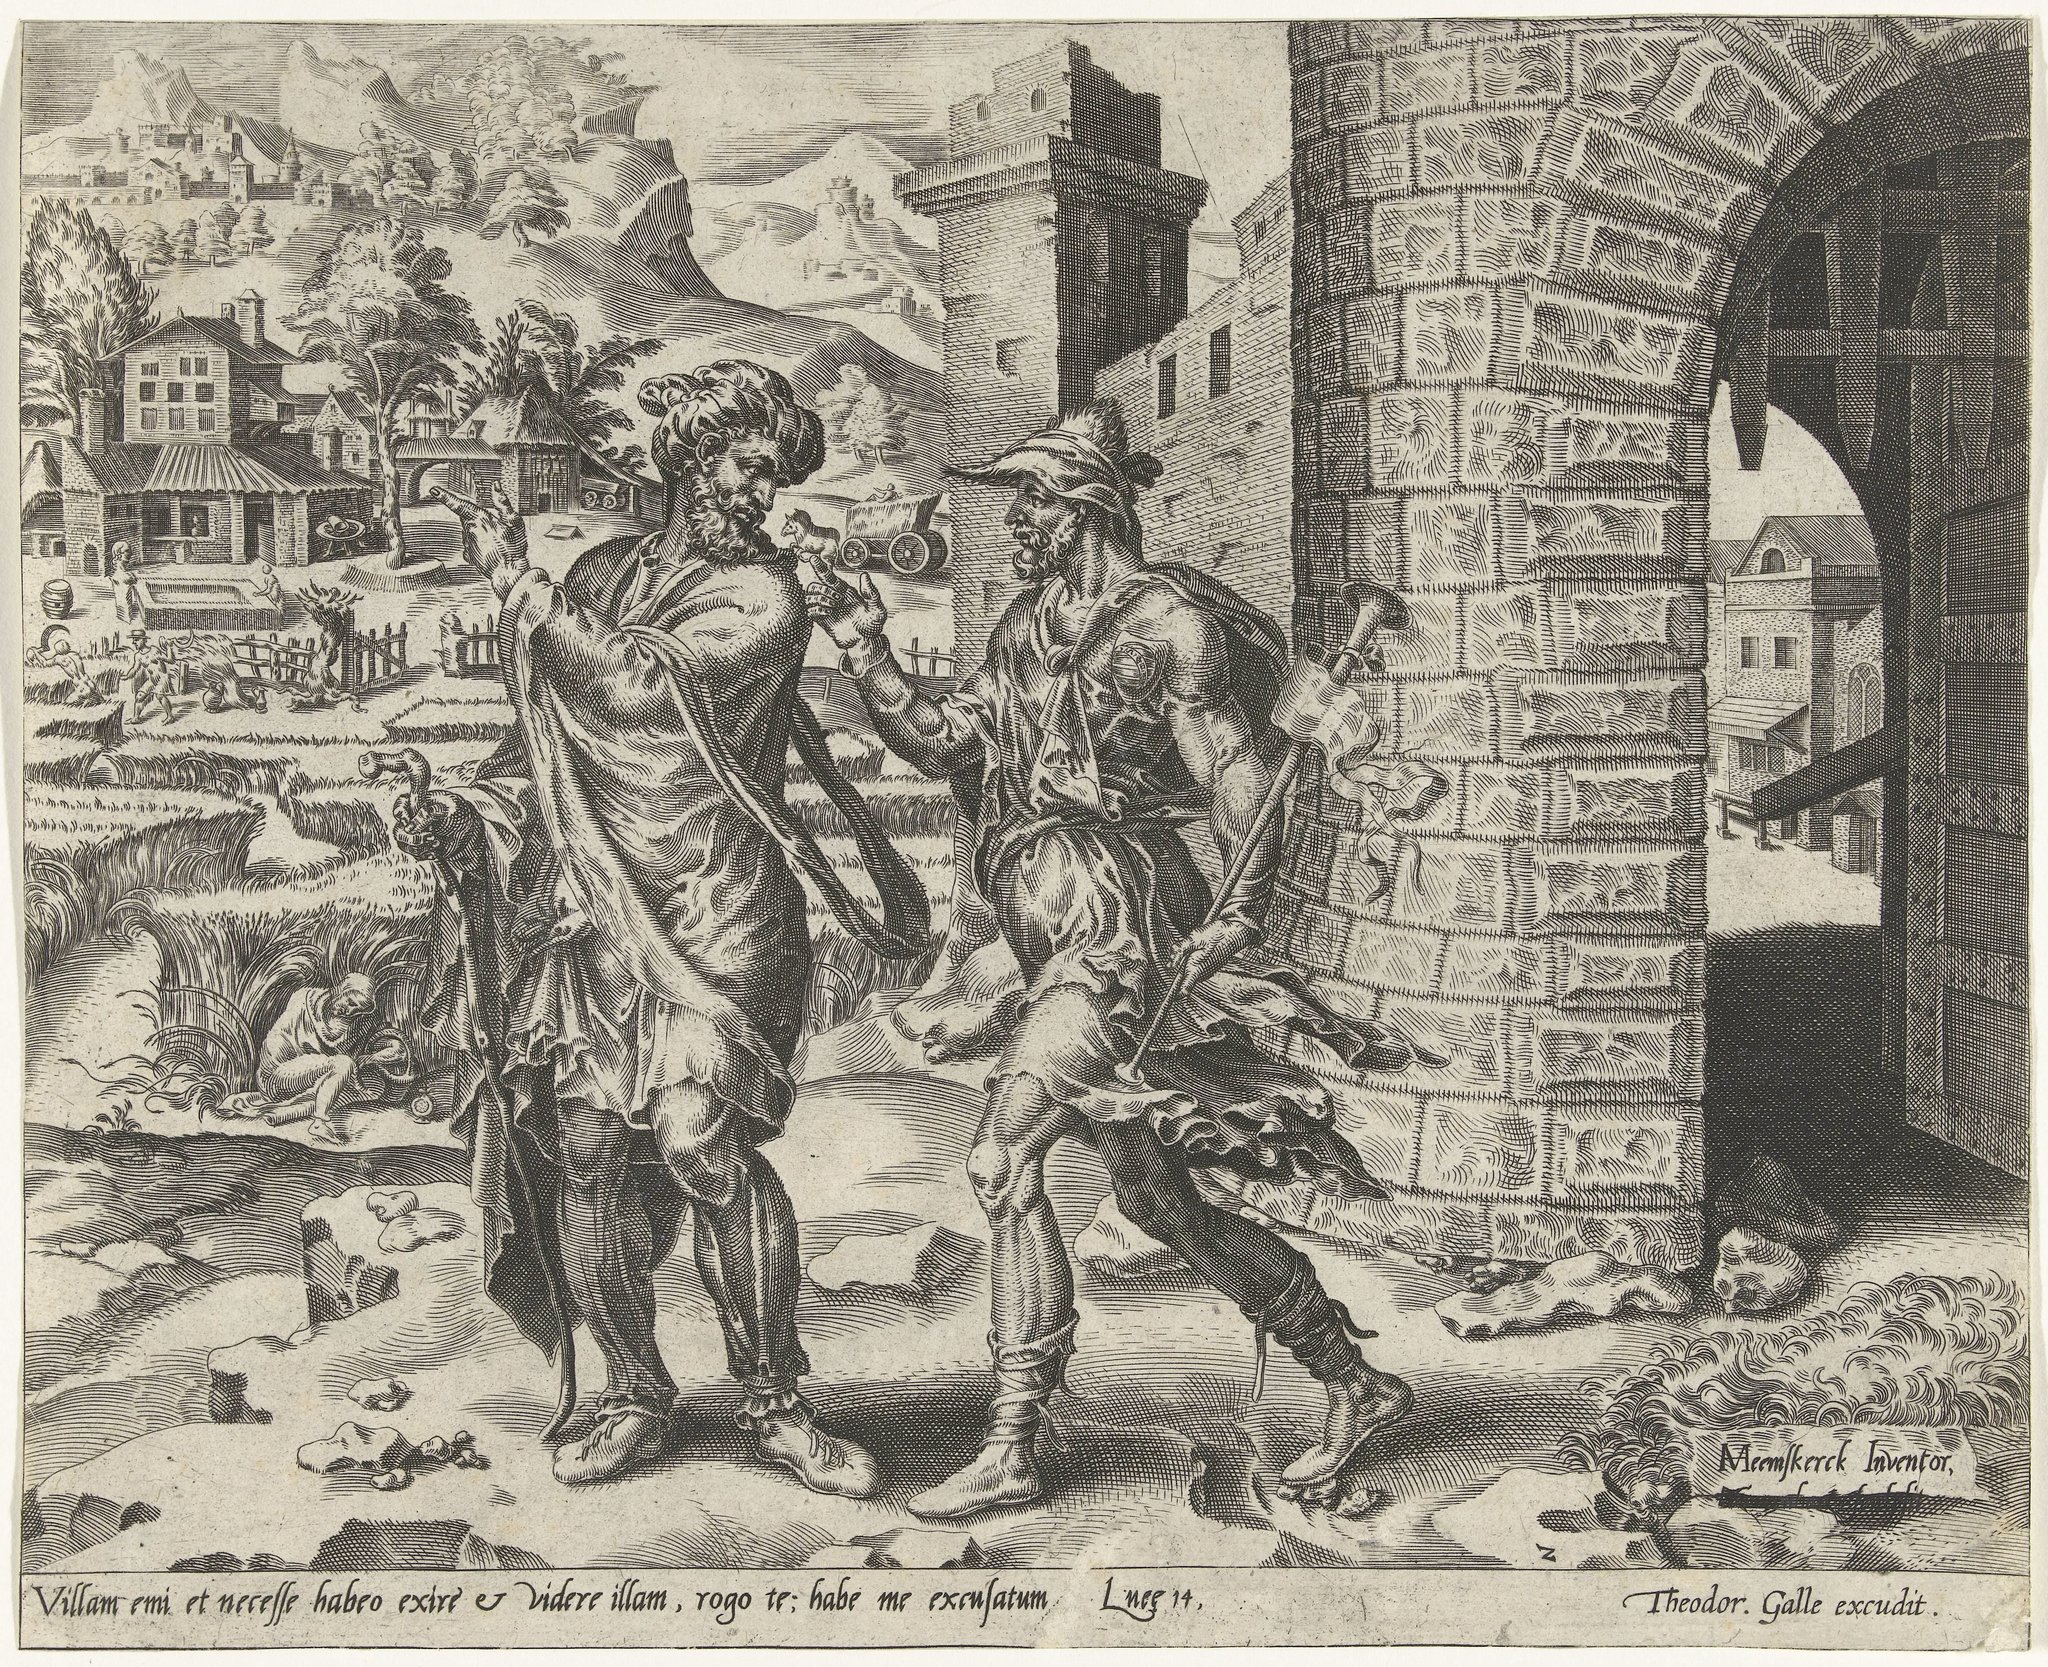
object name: print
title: Gelijkenis van een bruiloftsfeest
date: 1558-1559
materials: paper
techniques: engraving, etching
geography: antwerp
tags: those that are invited to the royal wedding-feast excuse themselves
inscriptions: collector's mark: Lugt 2228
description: De boodschapper komt bij de eerste gast en nodigt hem uit voor het feest. De gast verontschuldigt zich met het voorwendsel dat hij een nieuwe akker heeft gekocht. Hij wijst naar de akker op de achtergrond. De prent heeft een Latijns onderschrift en maakt deel uit van een zesdelige serie over de gelijkenis van een bruiloftsfeest.